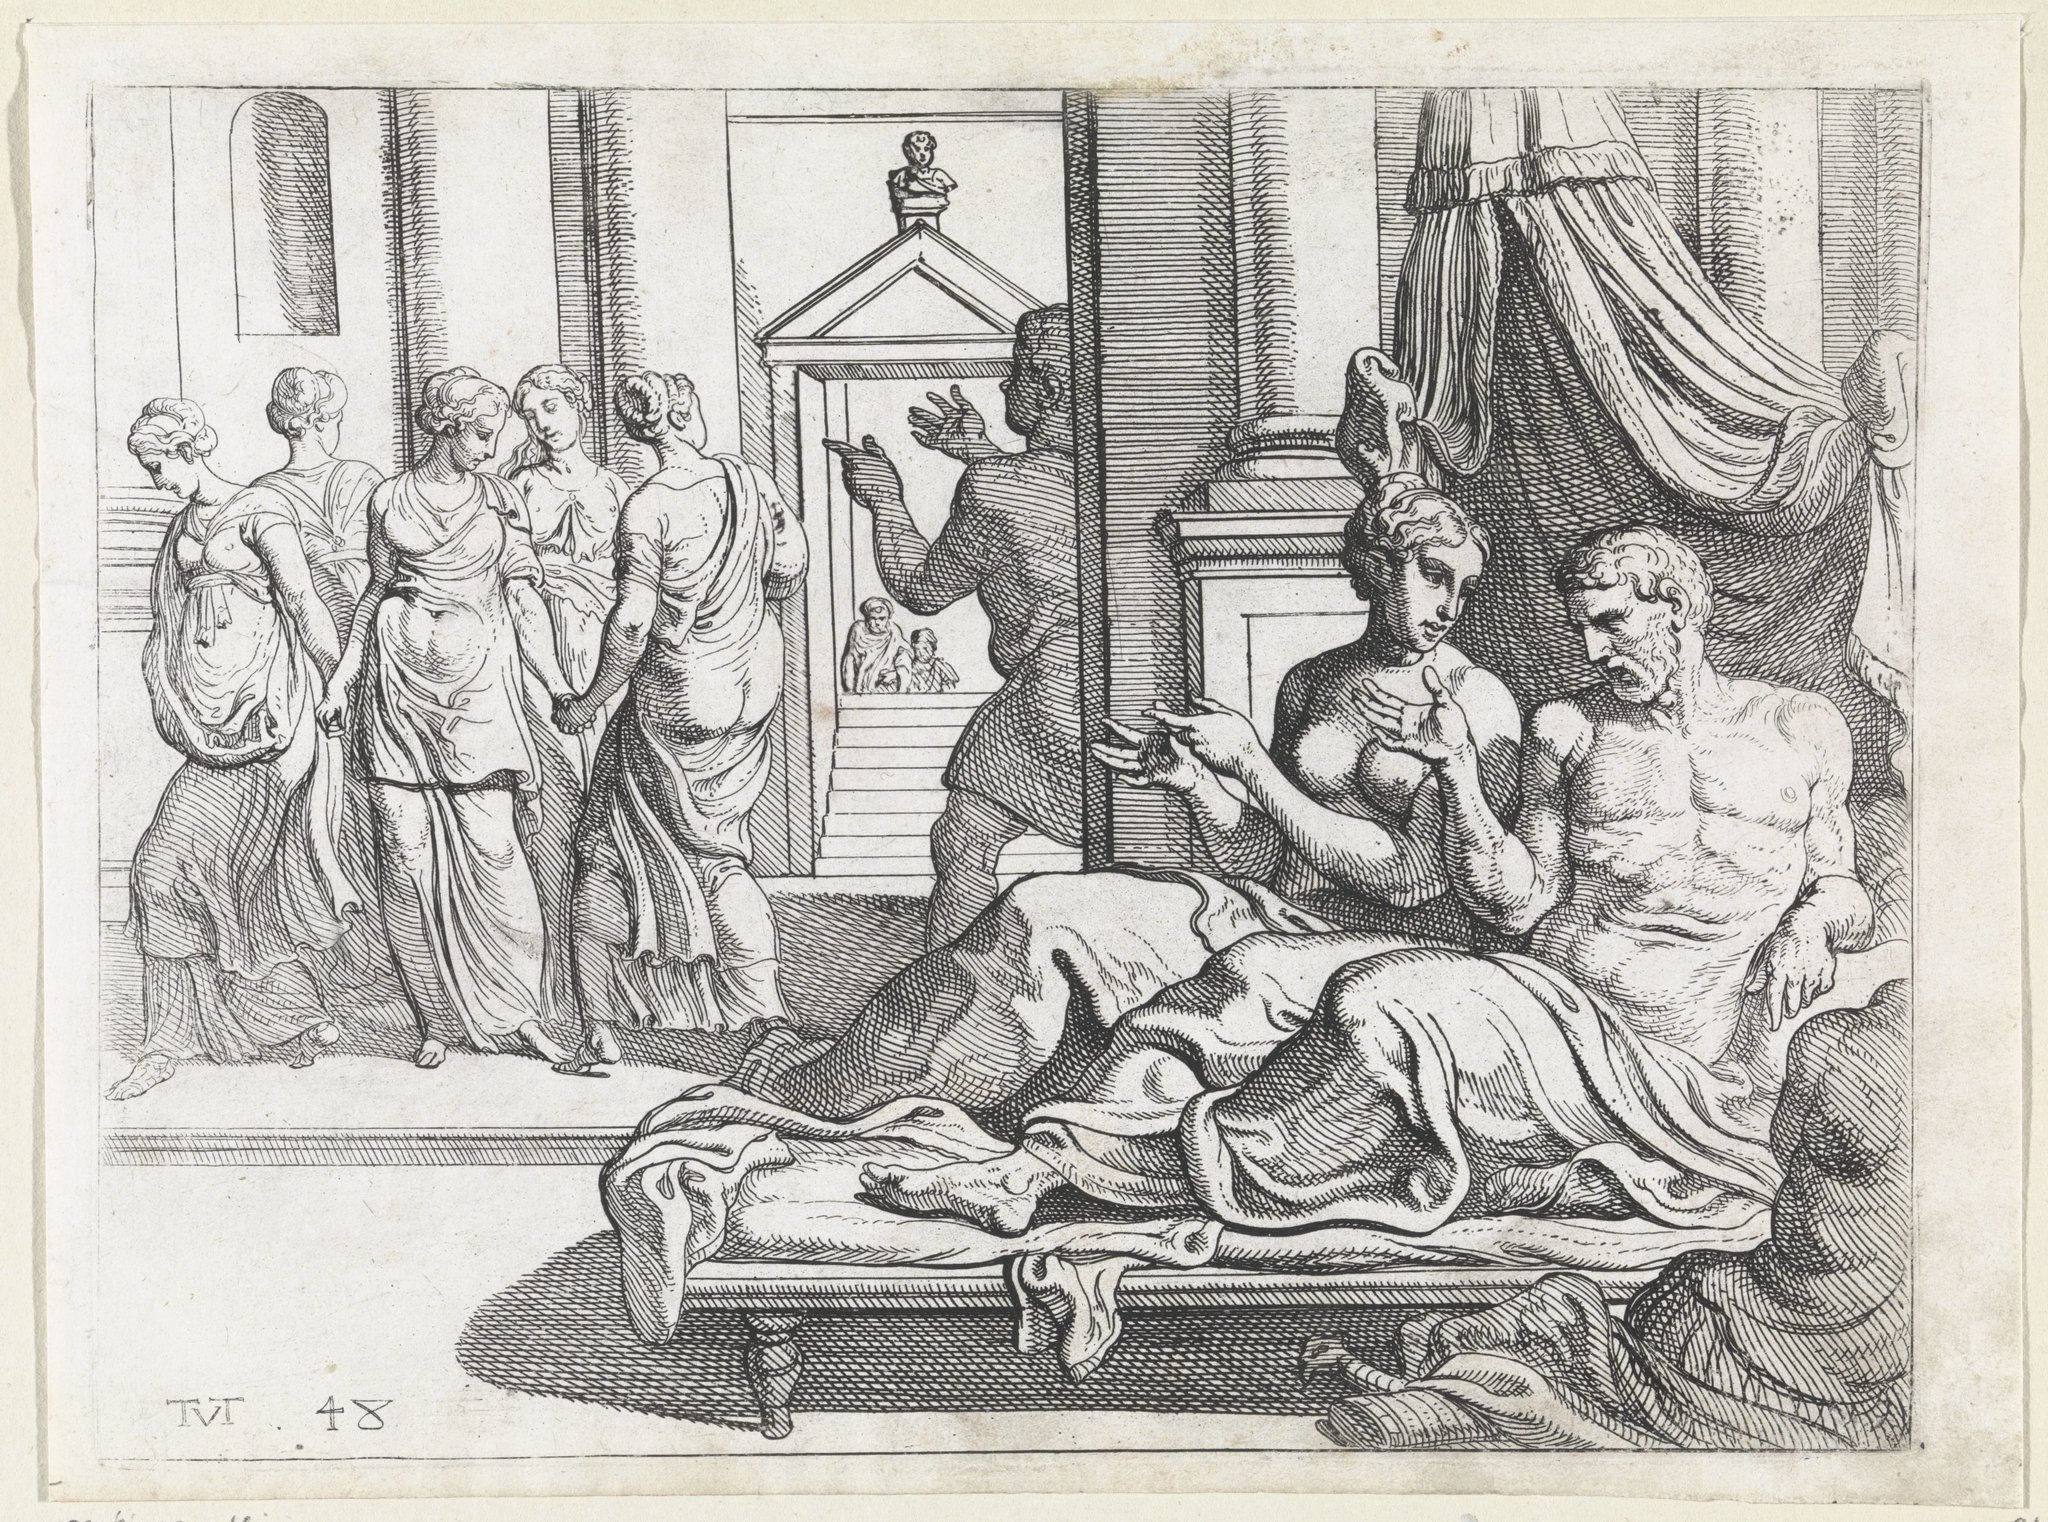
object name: print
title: Odysseus vertelt van zijn avonturen aan Penelope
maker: theodoor van thulden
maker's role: draughtsman, painter, print maker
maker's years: 1606-1669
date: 1632-1633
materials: paper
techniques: engraving, etching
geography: paris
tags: ulysses and penelope exchange their news in bed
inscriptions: collector's mark: Lugt 2228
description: Odysseus vertelt van zijn avonturen aan Penelope, terwijl ze in bed liggen.